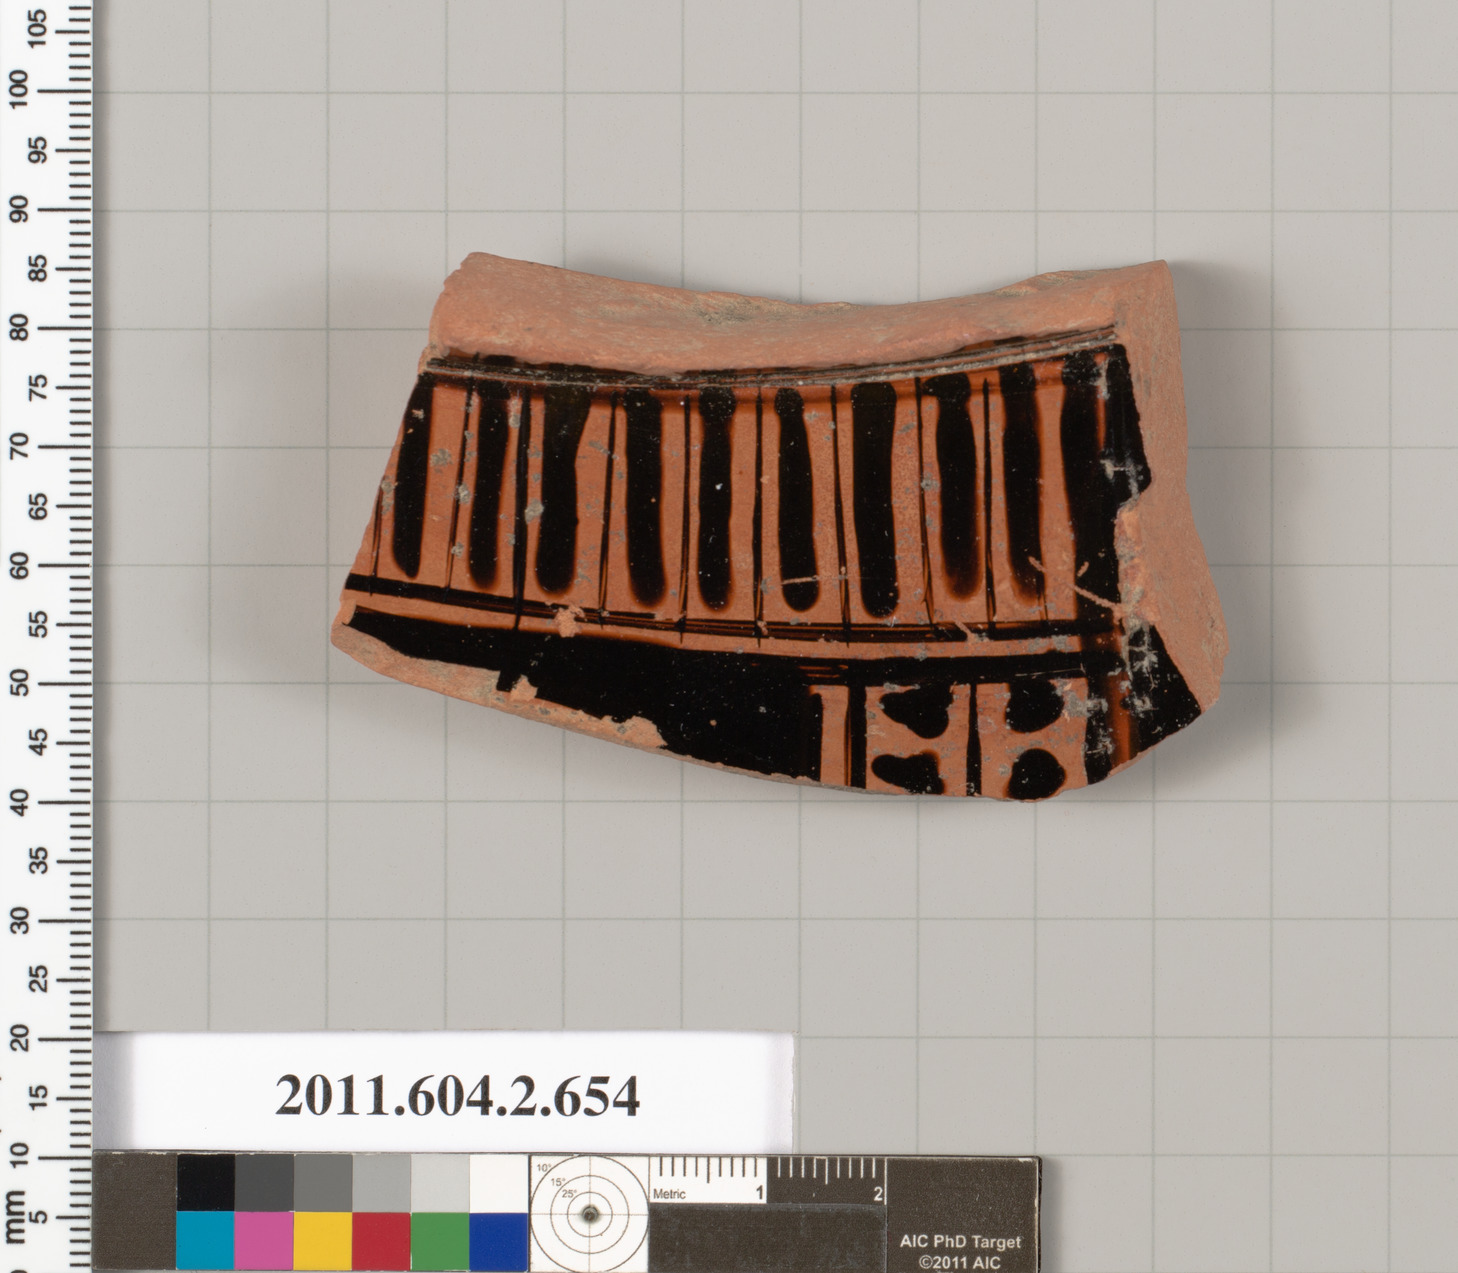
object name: column krater fragment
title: Terracotta fragment of a column-krater (bowl for mixing wine and water)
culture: greek, attic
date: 460-450 BCE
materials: terracotta